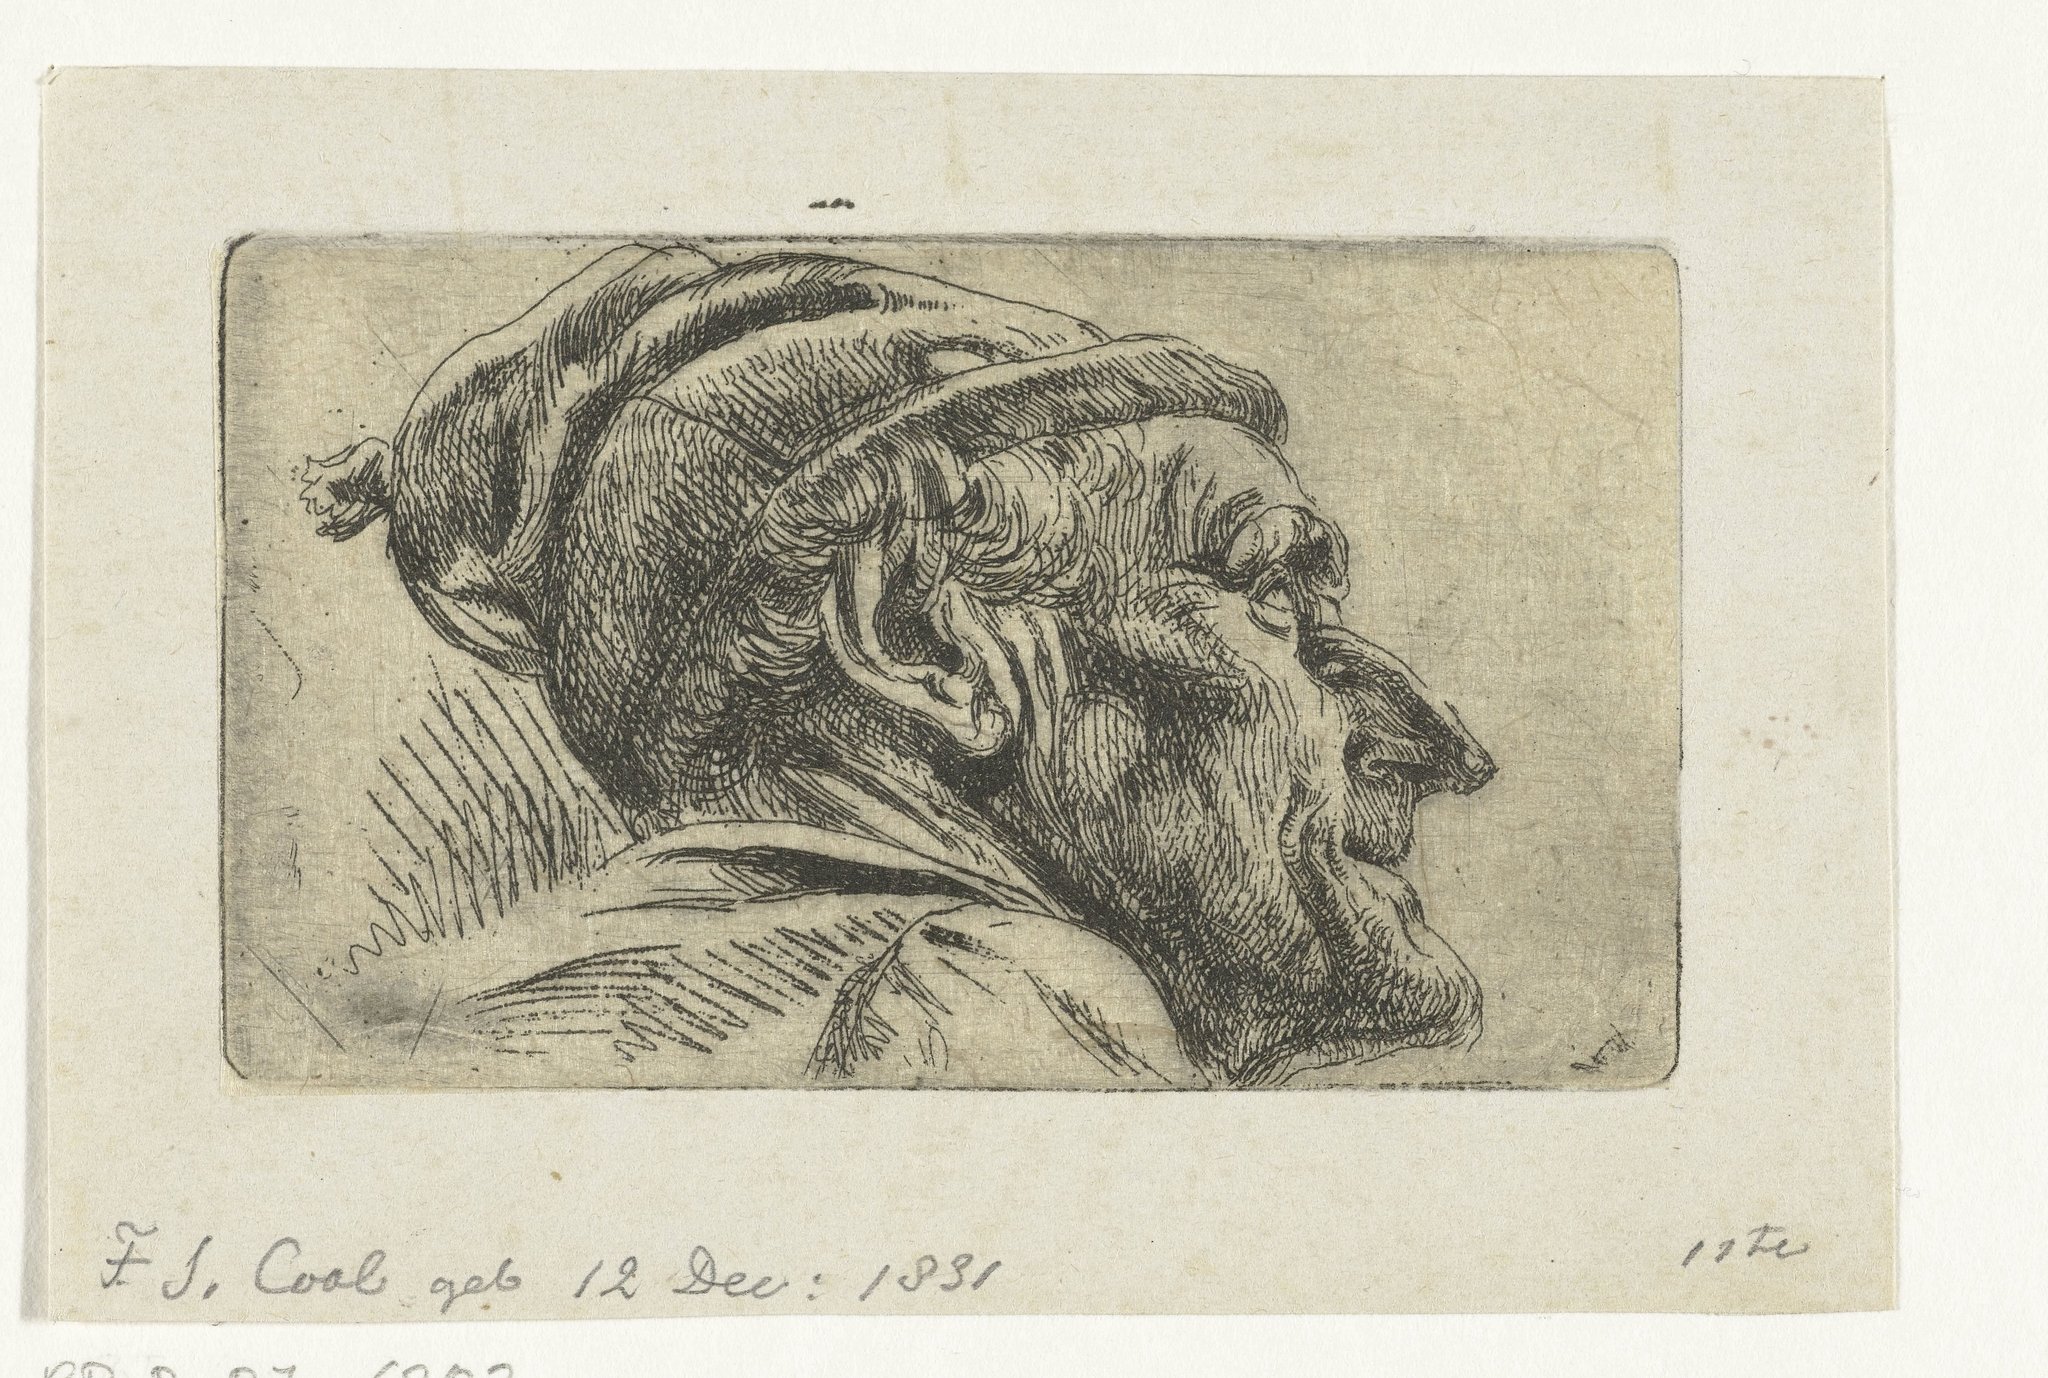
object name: print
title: Hoofd van een boer met muts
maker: thomas simon cool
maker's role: draughtsman, print maker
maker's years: 1831-1870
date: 1862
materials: paper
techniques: etching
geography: netherlands